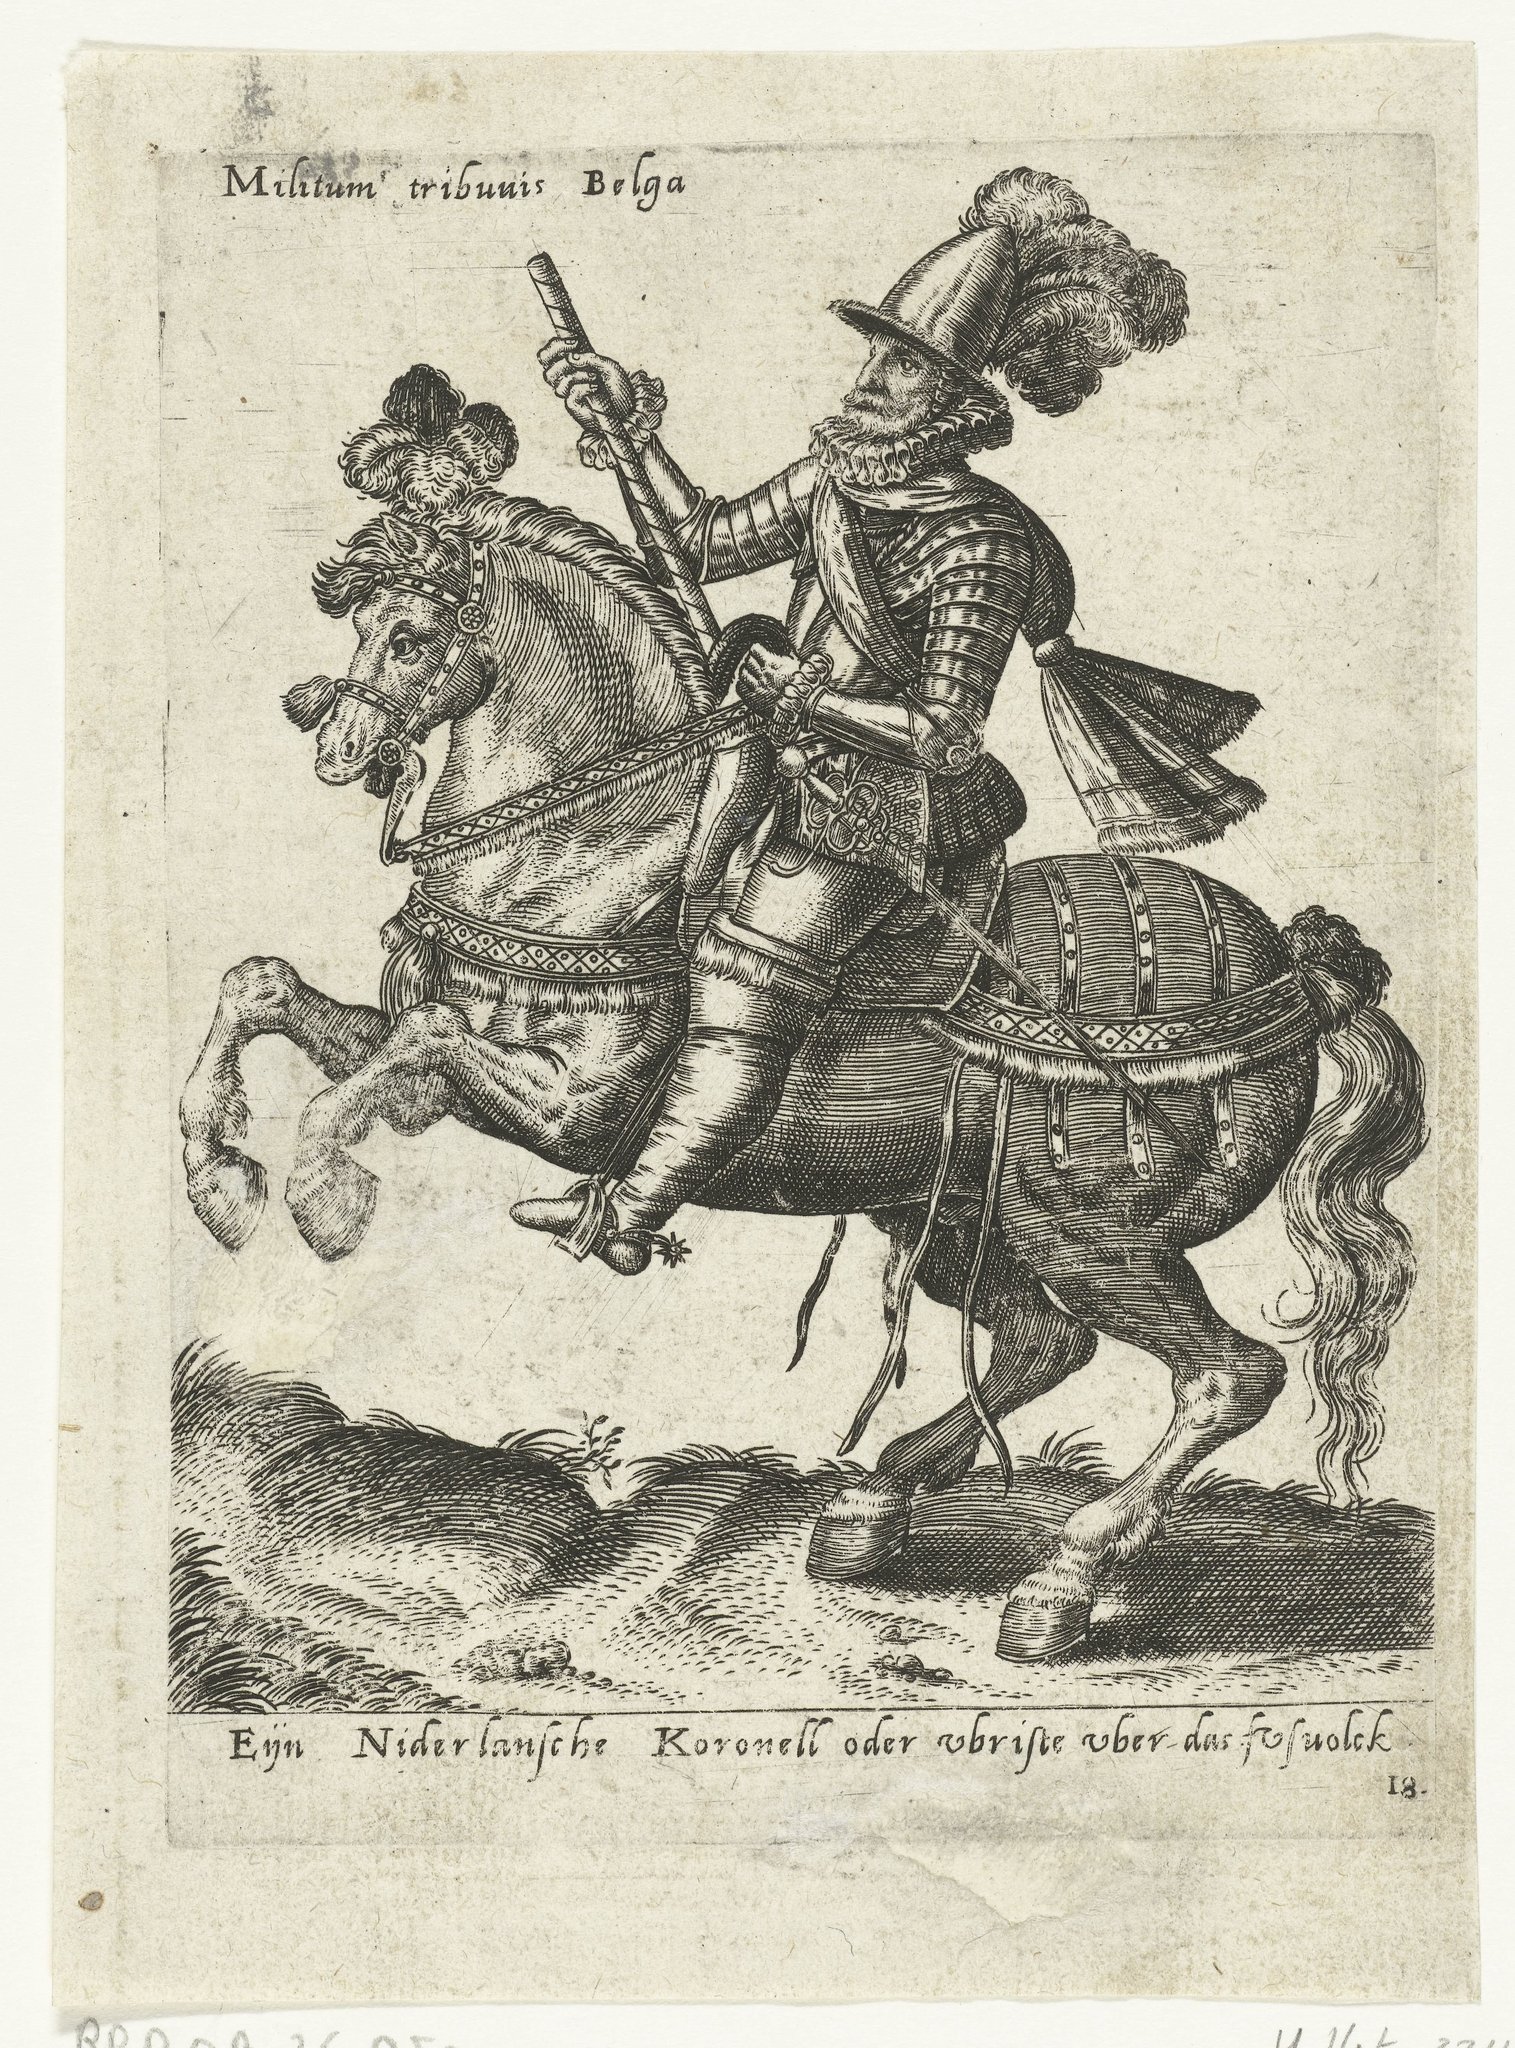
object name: costume print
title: Nederlandse ruiter-commandant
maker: abraham de bruyn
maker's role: print maker, publisher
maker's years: 1540-1587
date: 1577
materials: paper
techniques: engraving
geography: cologne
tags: commander-in-chief, general, marshal, warfare; military affairs (+ cavalry, horsemen), folk costume, regional costume, military clothing and other equipment (uniforms, cap, armour, helmet, etc.), baton of general, europeans (with name)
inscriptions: collector's mark: Lugt 2228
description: Prent oorspronkelijk verschenen in 'Equitum descripcio, quomodo equestres copie, nostra hac aetate, in sua armatura, per cunttas, videlicet Europae, Asiae et Affrice, nationes in re militare sese habent nunc primum', Keulen 1577.